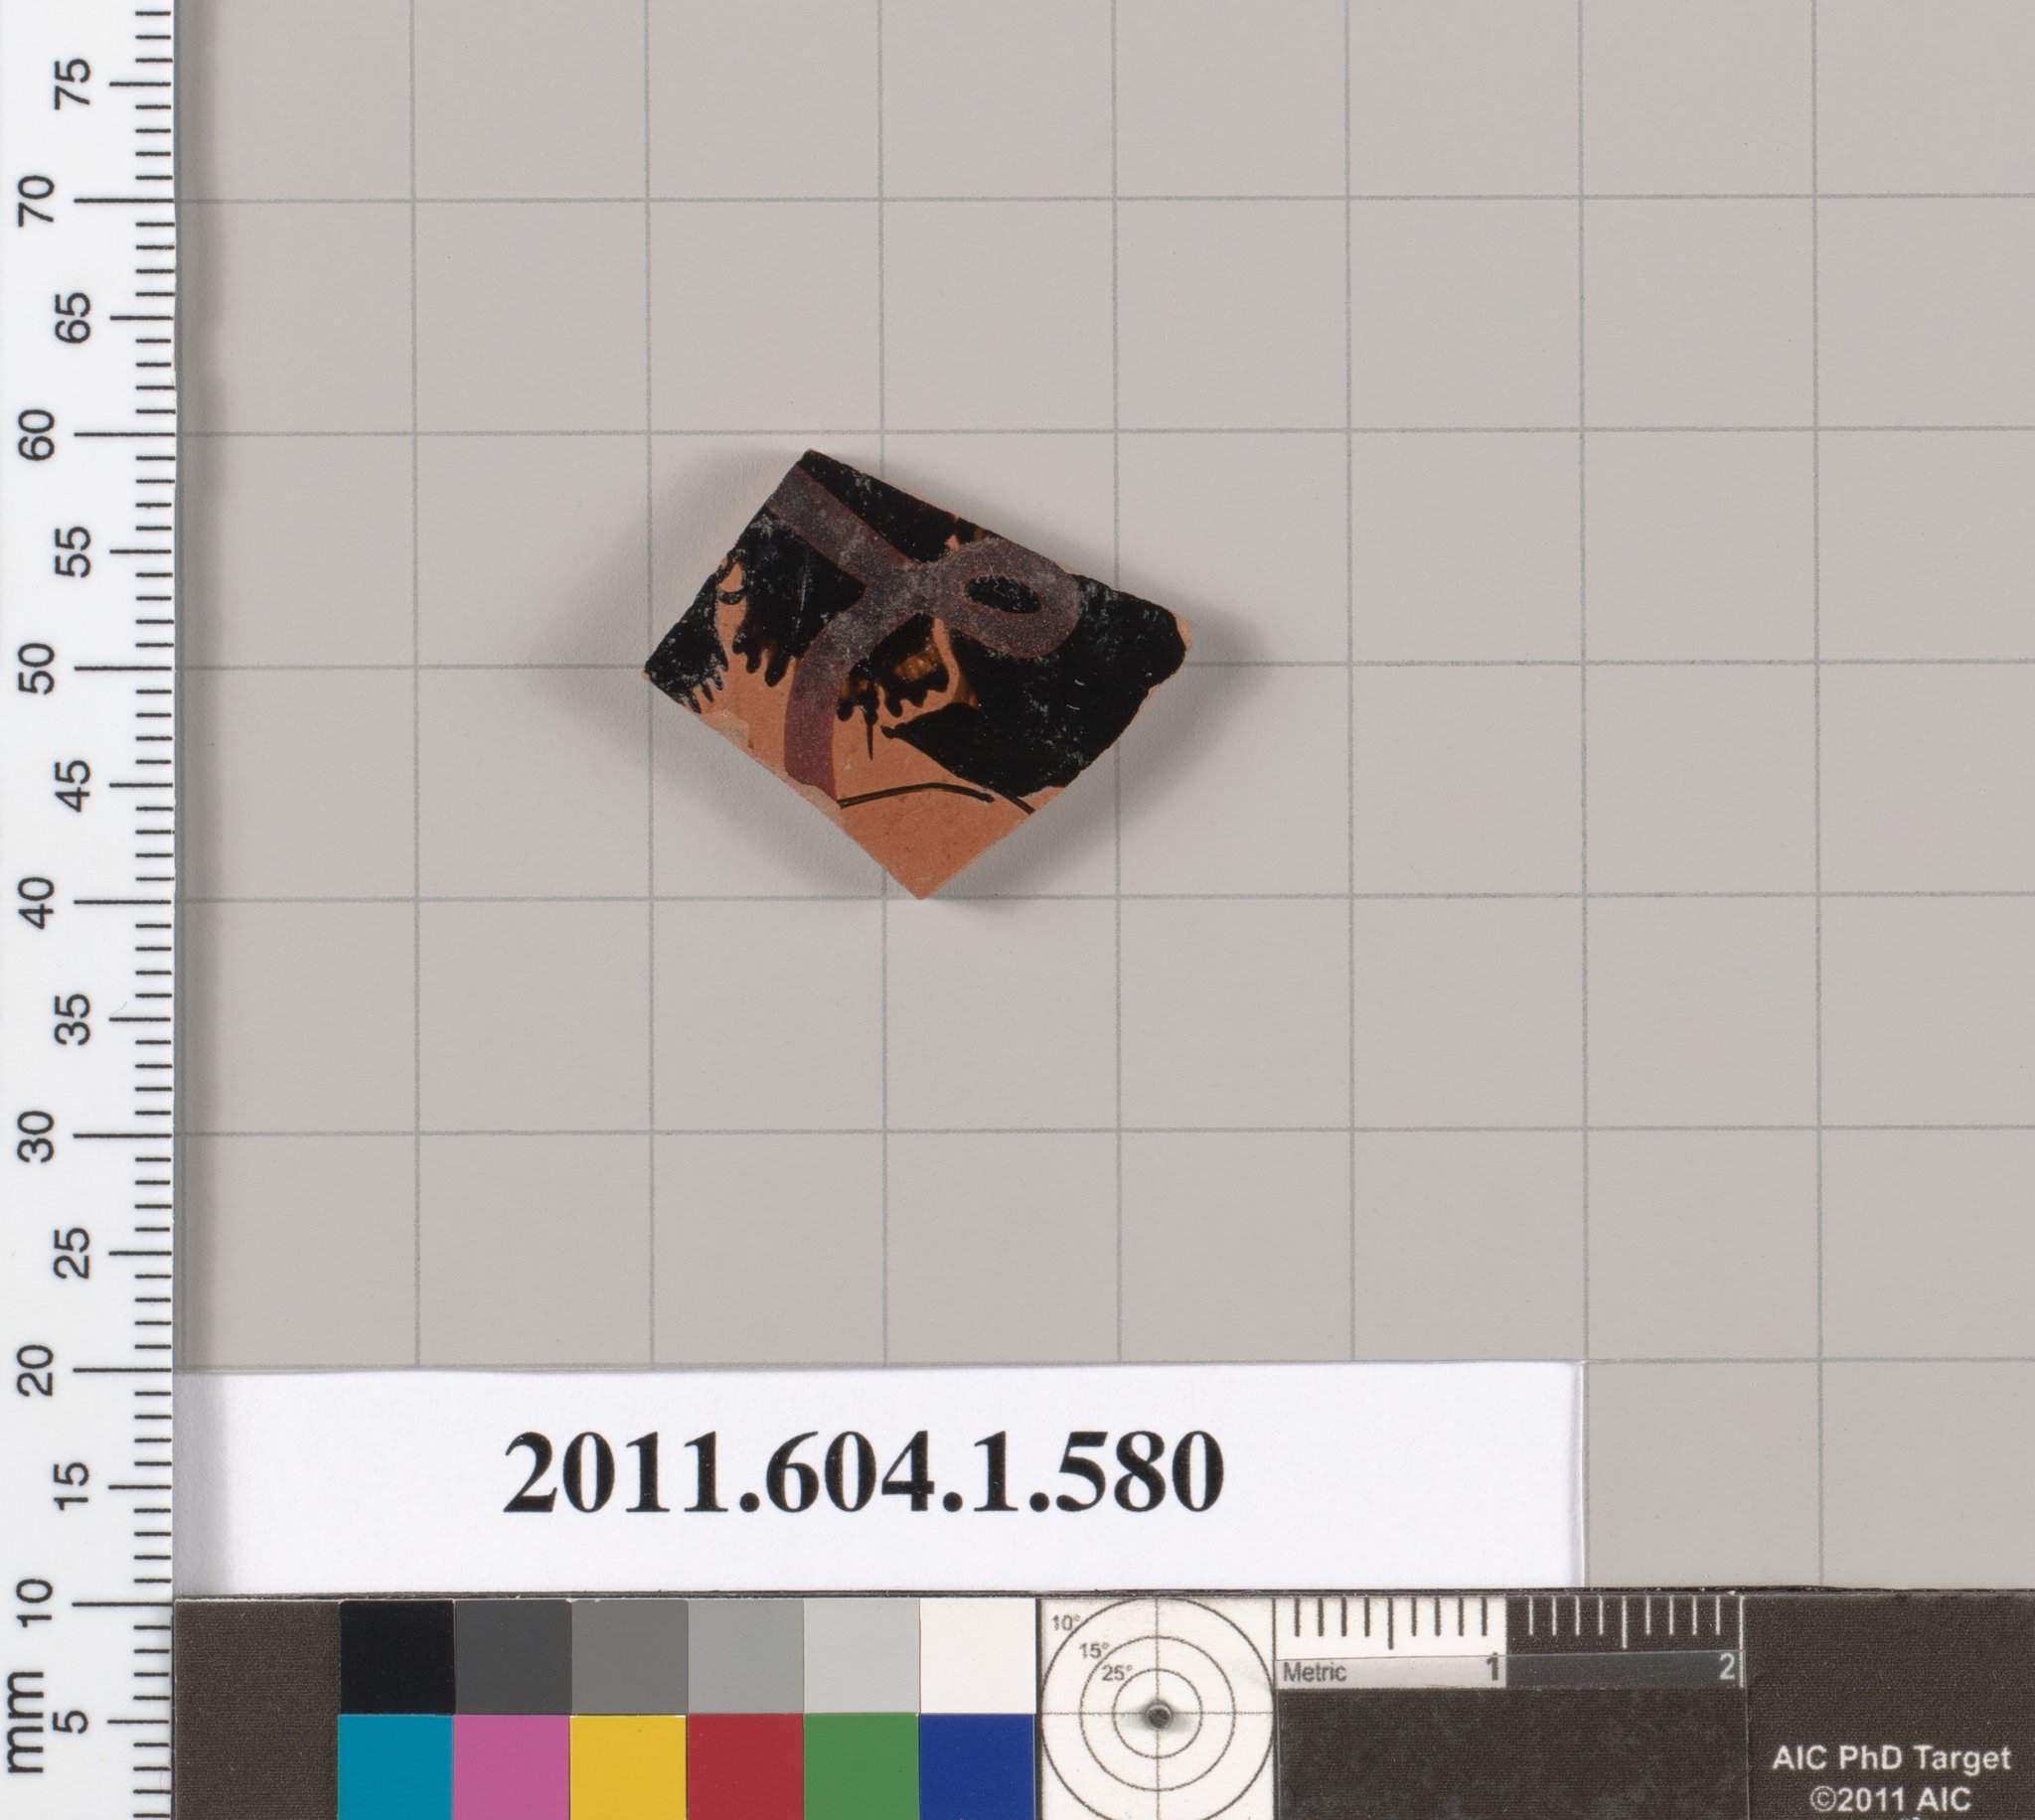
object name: kylix fragment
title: Terracotta fragment of a kylix (drinking cup)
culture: greek, attic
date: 490-480 BCE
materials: terracotta